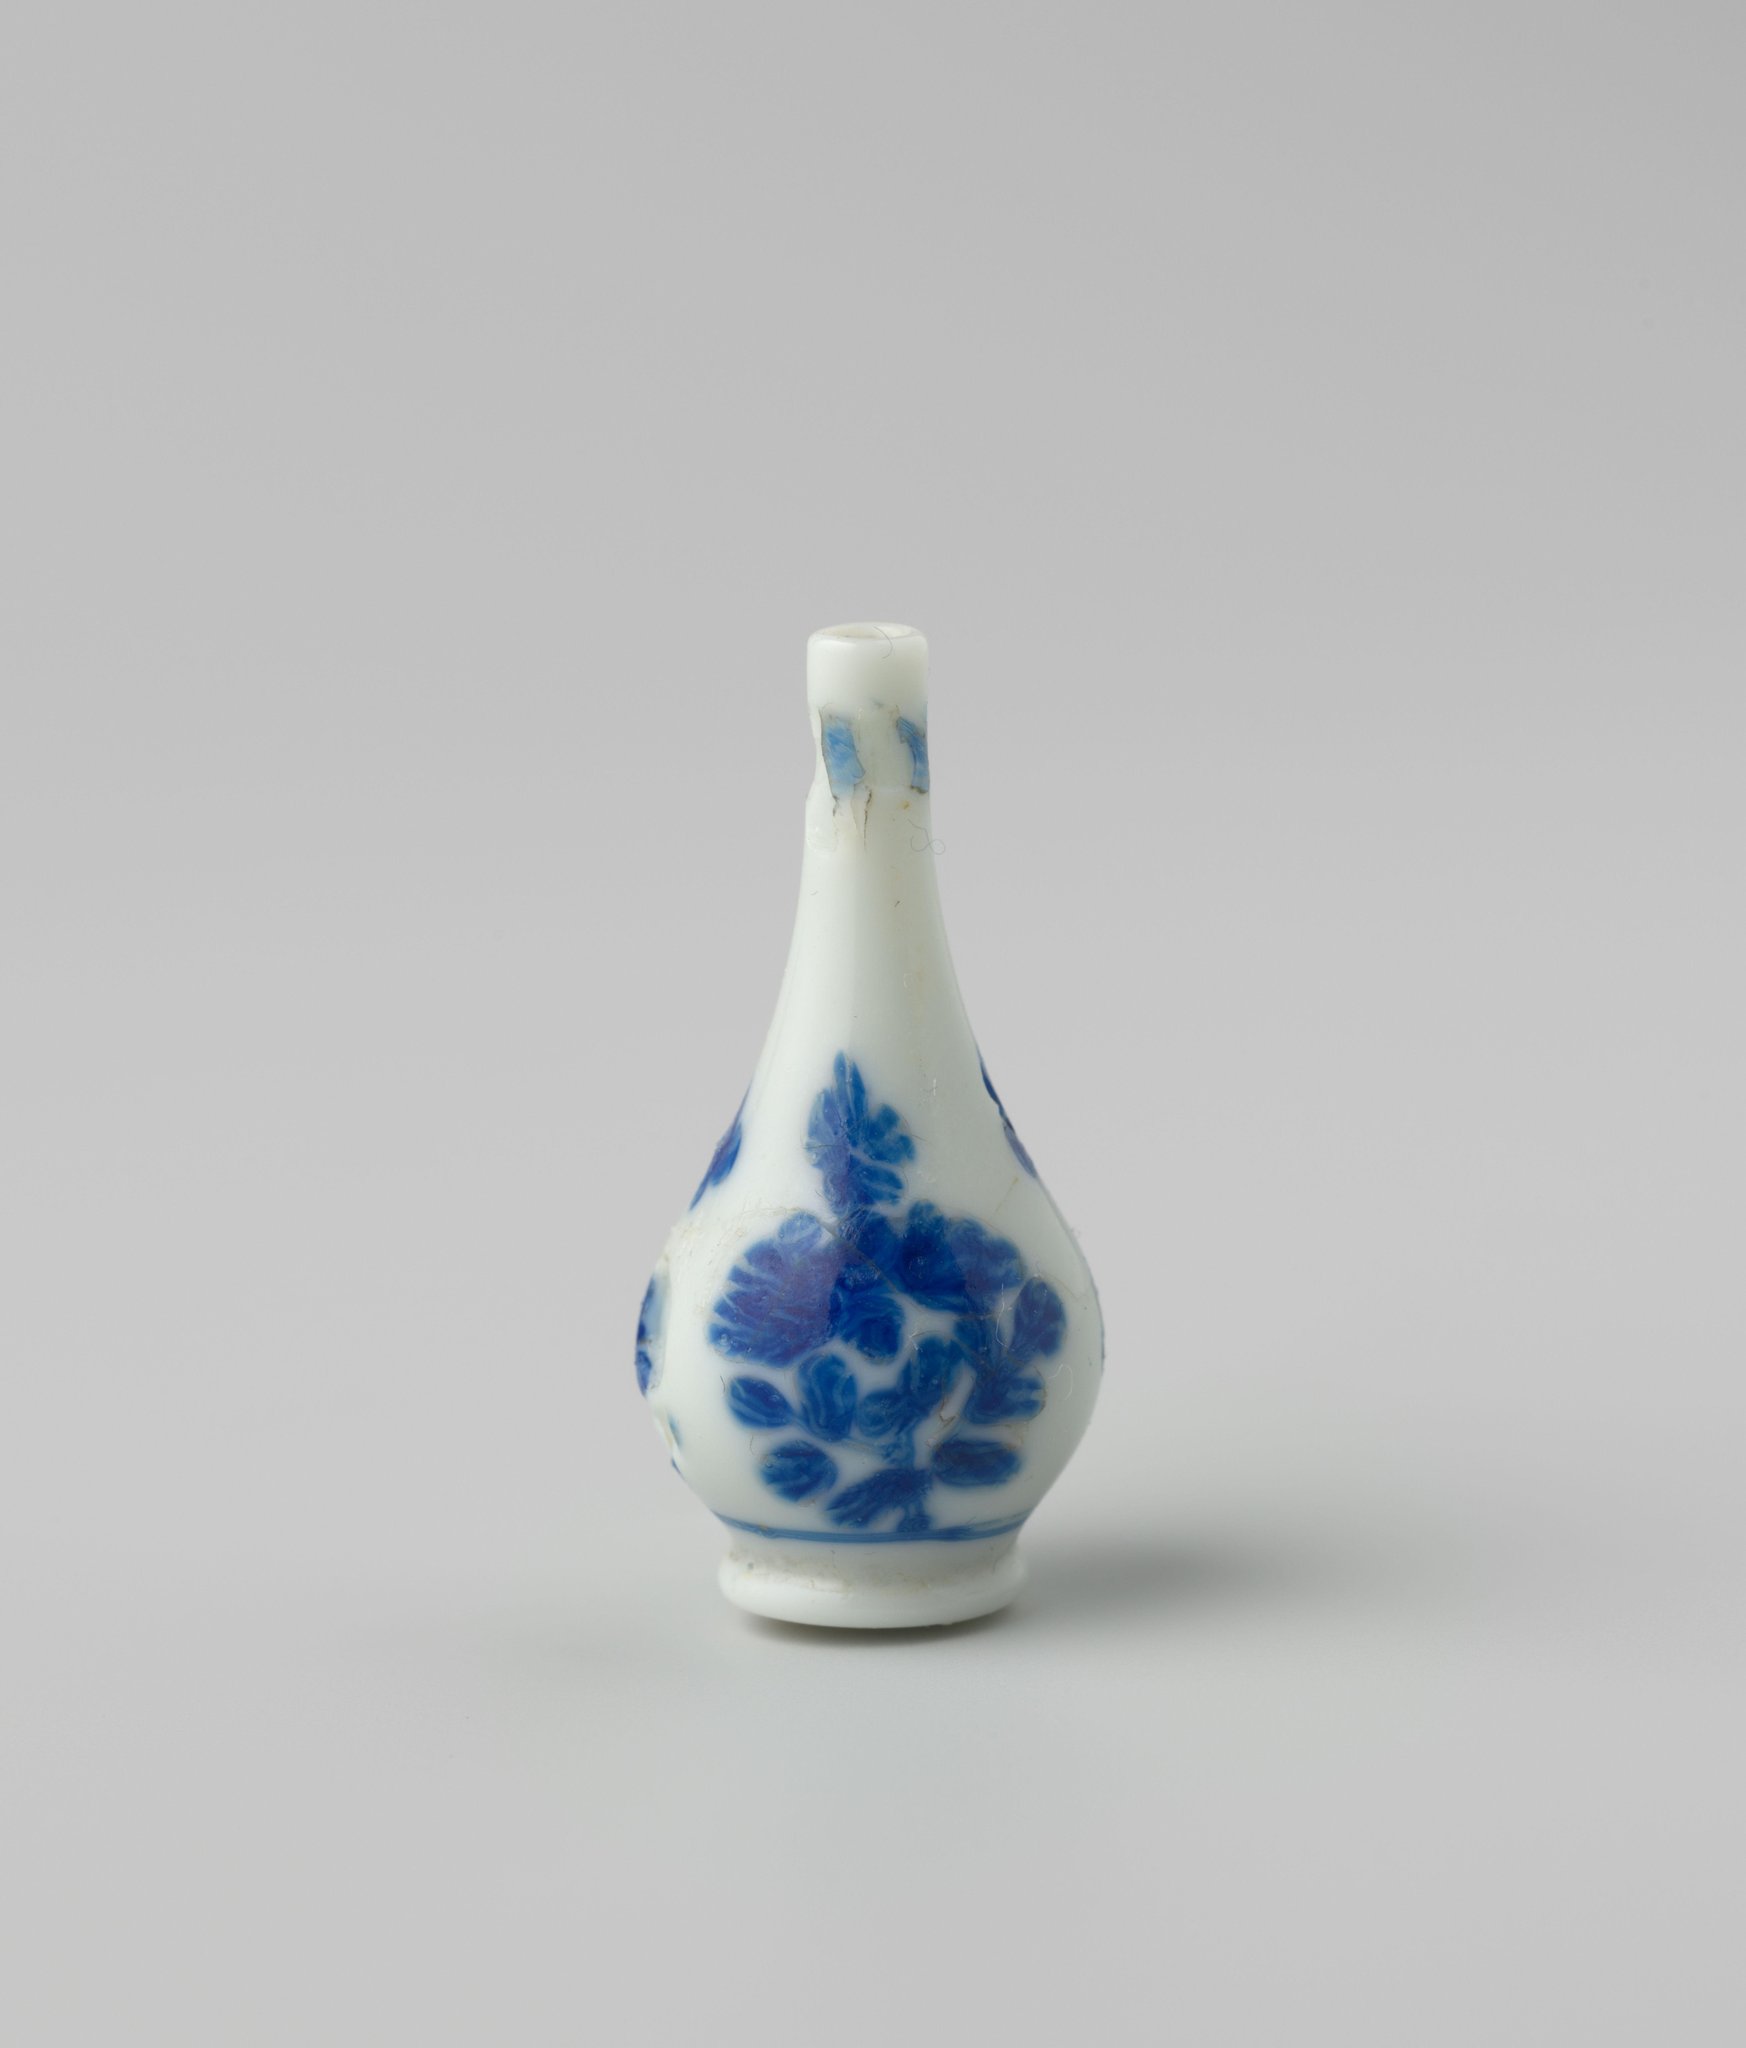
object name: sprinkler flask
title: Fles van melkglas met blauwe emailverf beschildering, imitatie Chinees porselein; peervormig op standring, decoratie van bloem tuilen.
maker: Anonymous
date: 1675-1710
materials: glass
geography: amsterdam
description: Fles van melkglas met blauwe emailverf beschildering, imitatie Chinees blauw porselein; model peervormig op standring, decoratie van bloemtuilen. (Dik glas, gedeeltelijk 'afgeschilderd').